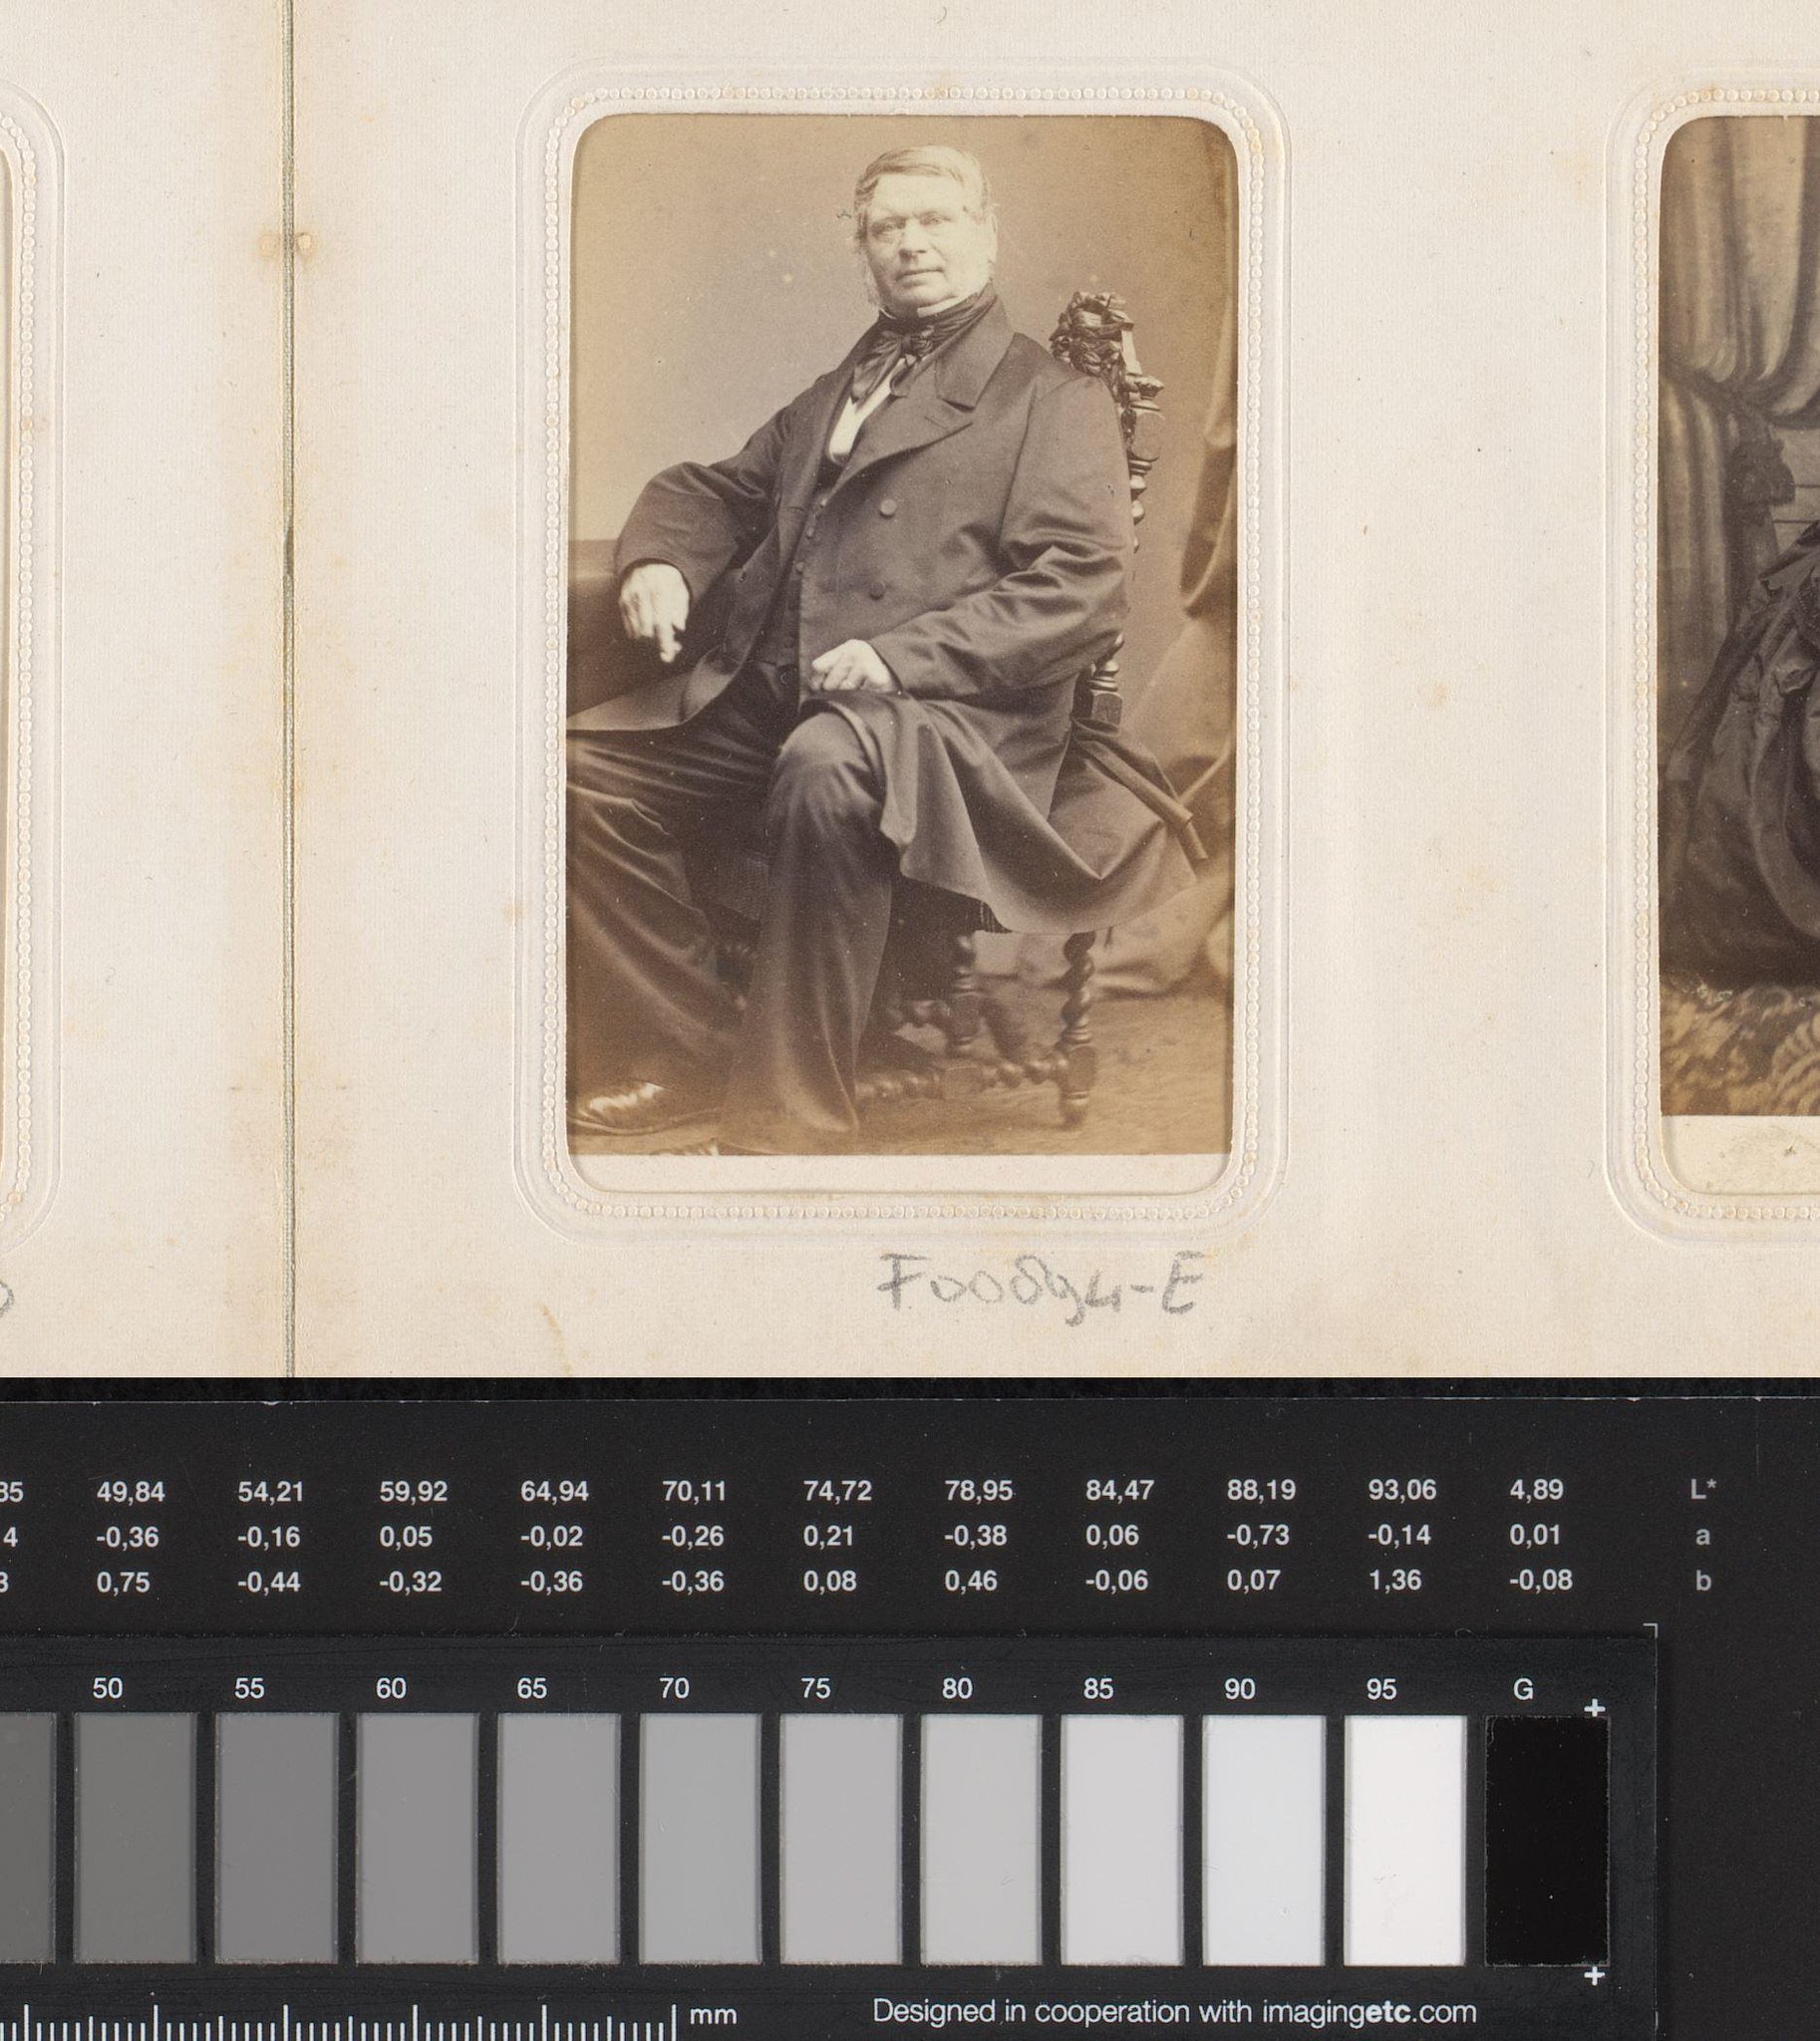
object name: album leaf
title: Portret van een zittende man met bril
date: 1860-1900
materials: cardboard, photographic support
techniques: albumen print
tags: eyeglasses, spectacles, sitting figure, adult man, historical persons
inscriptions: inscription: ‘Photogr Atelier/ Wegner & Mottu,/ Prinsengracht BB 439/ Amsterdam’